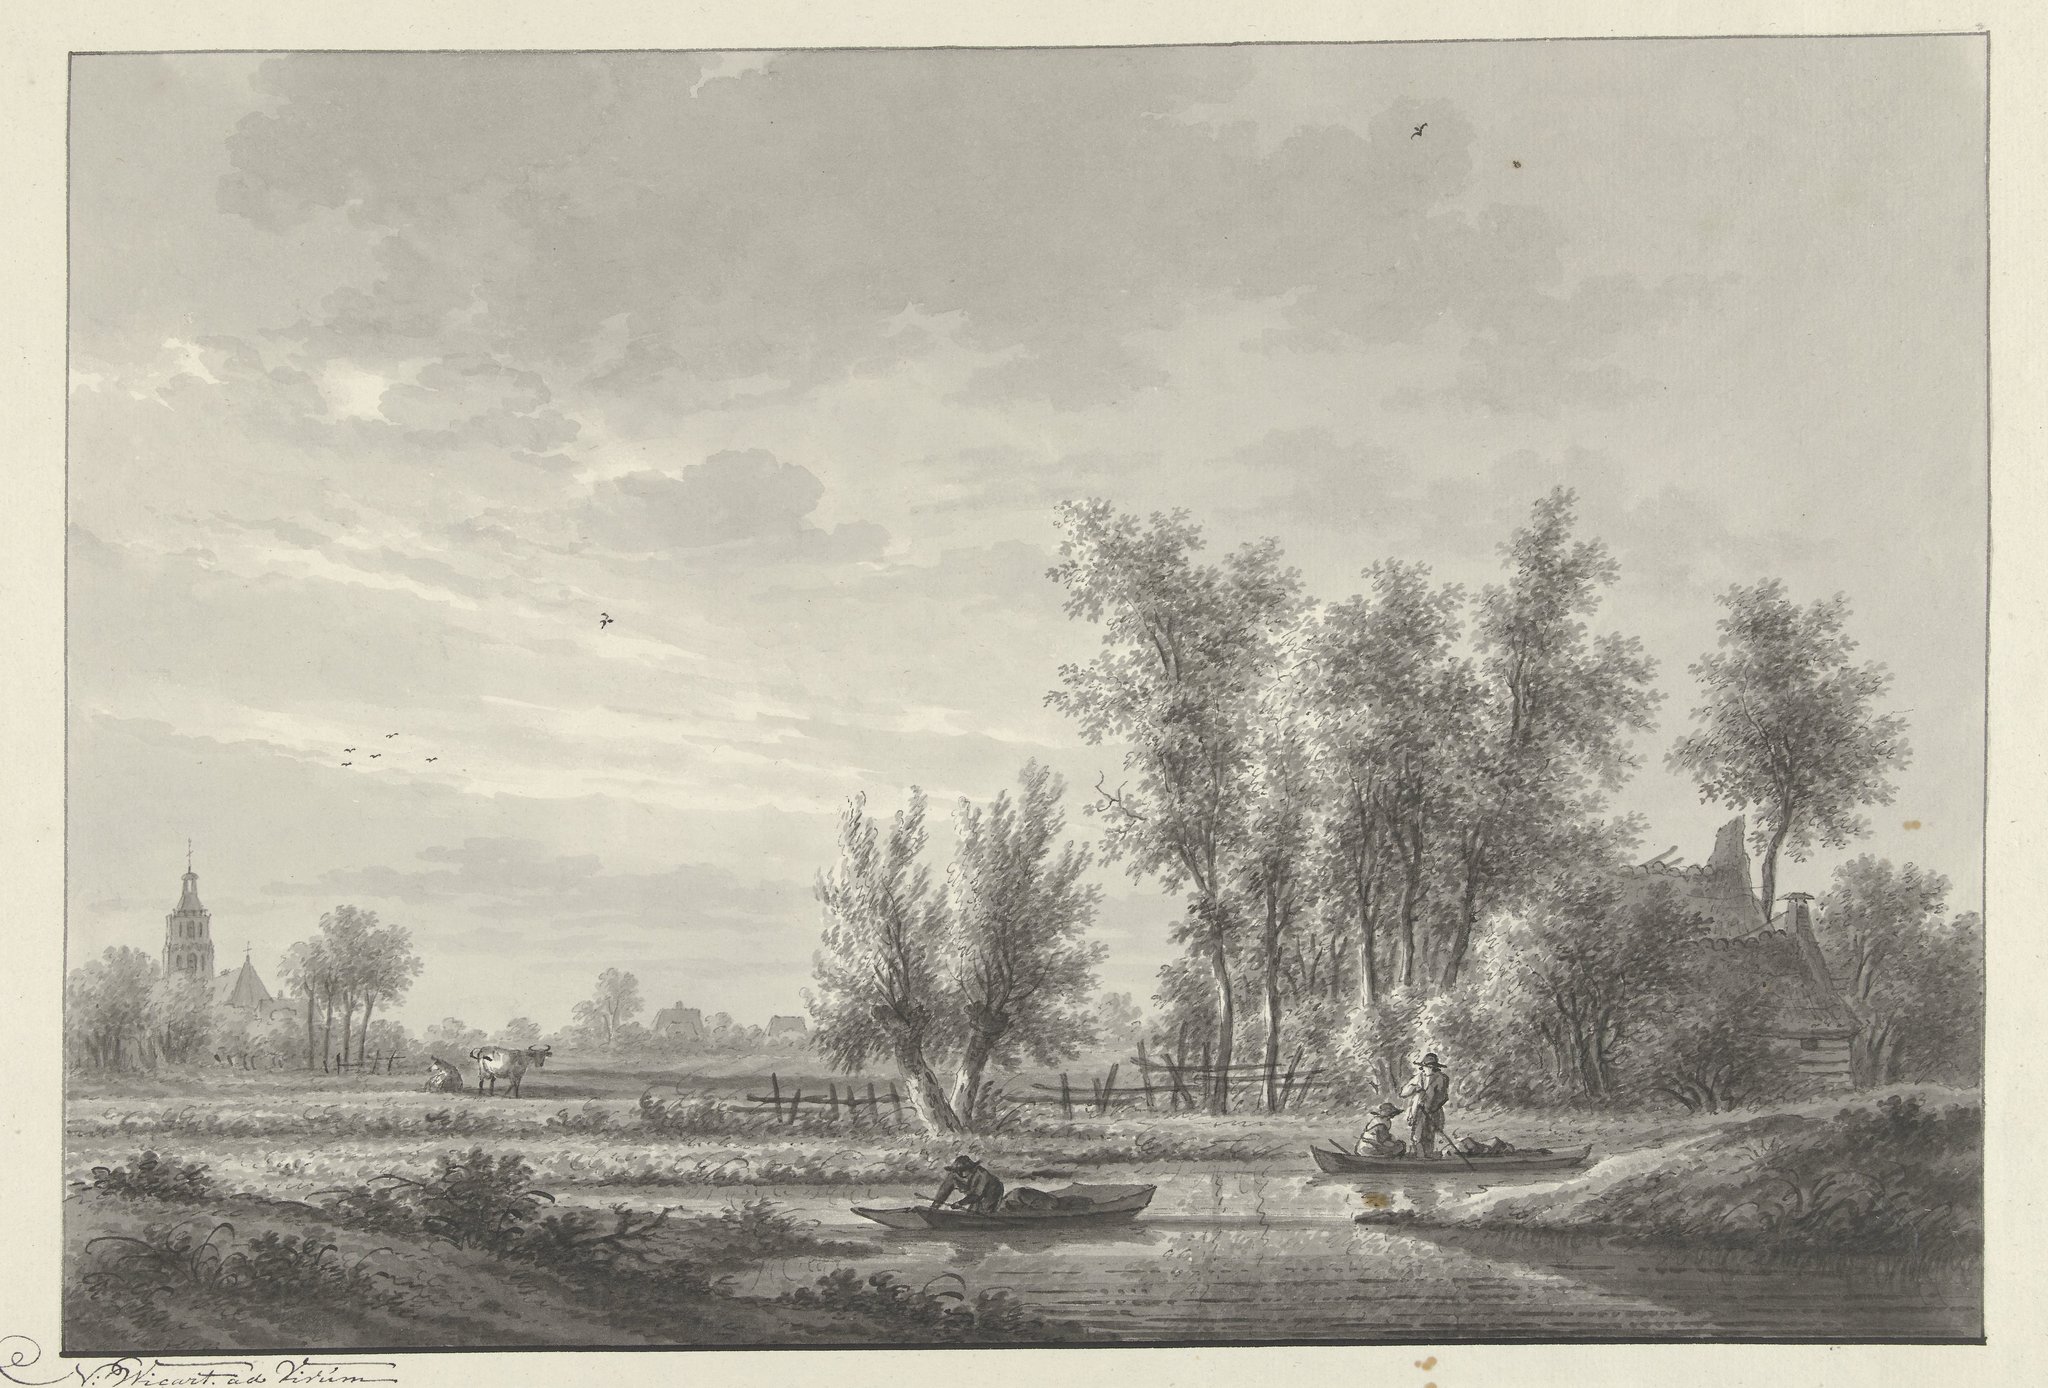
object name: drawing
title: Gezicht op Houten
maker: nicolaas wicart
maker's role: draughtsman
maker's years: 1748-1815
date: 1758-1815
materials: ink, paper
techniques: brush, pen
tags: village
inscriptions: inscription: ‘N:Wicart ad Vivum’, inscription: ‘'t Dorp Houten’